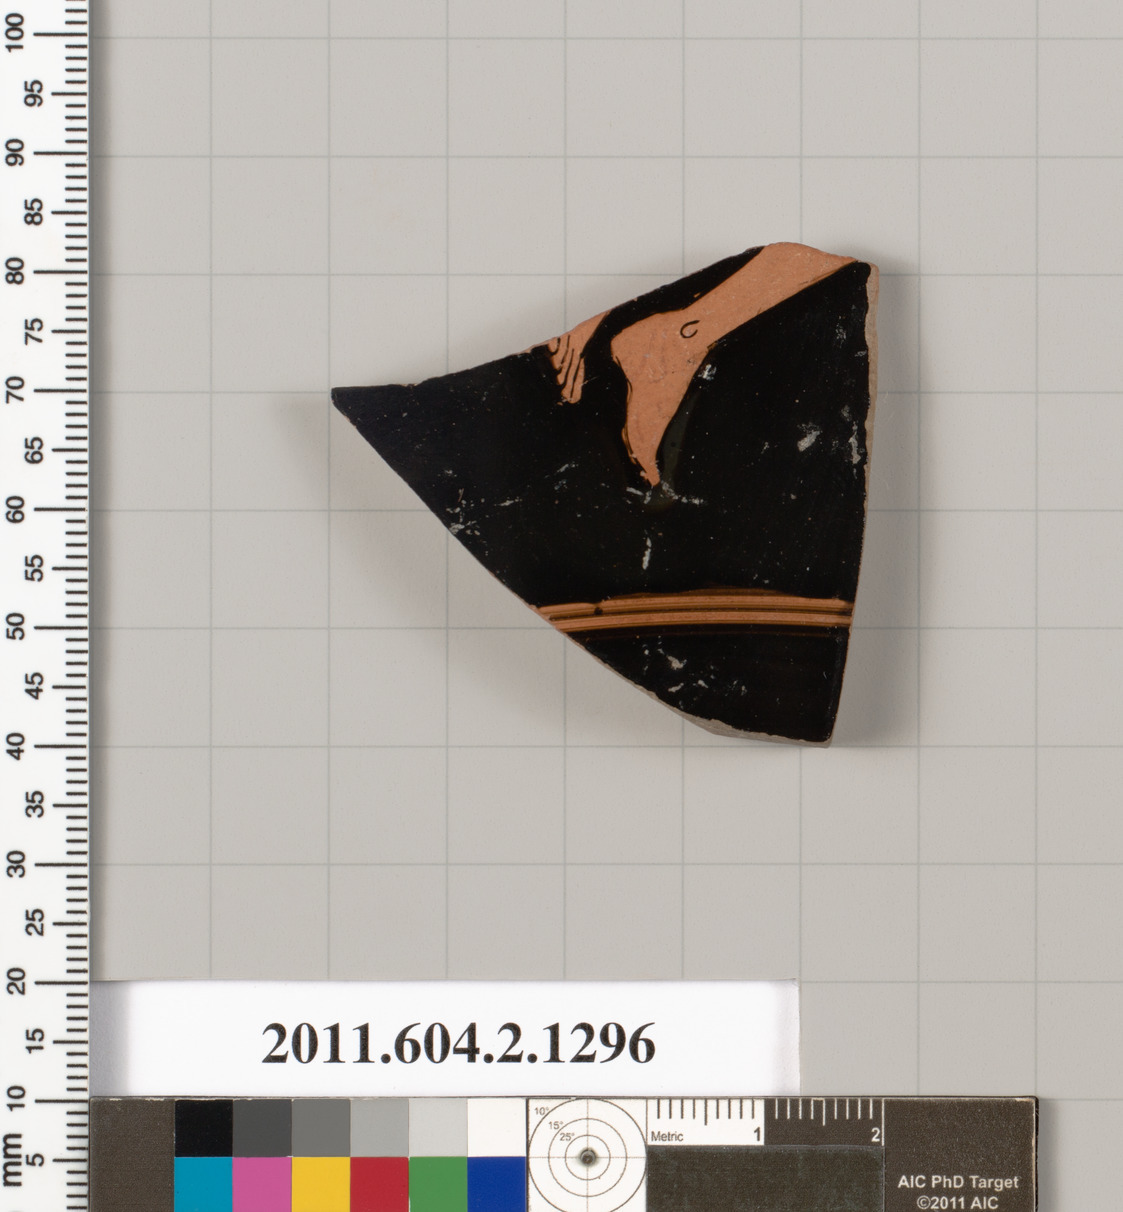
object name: skyphos fragment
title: Terracotta fragment of a skyphos (deep drinking cup)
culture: greek, attic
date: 475-451 BCE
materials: terracotta